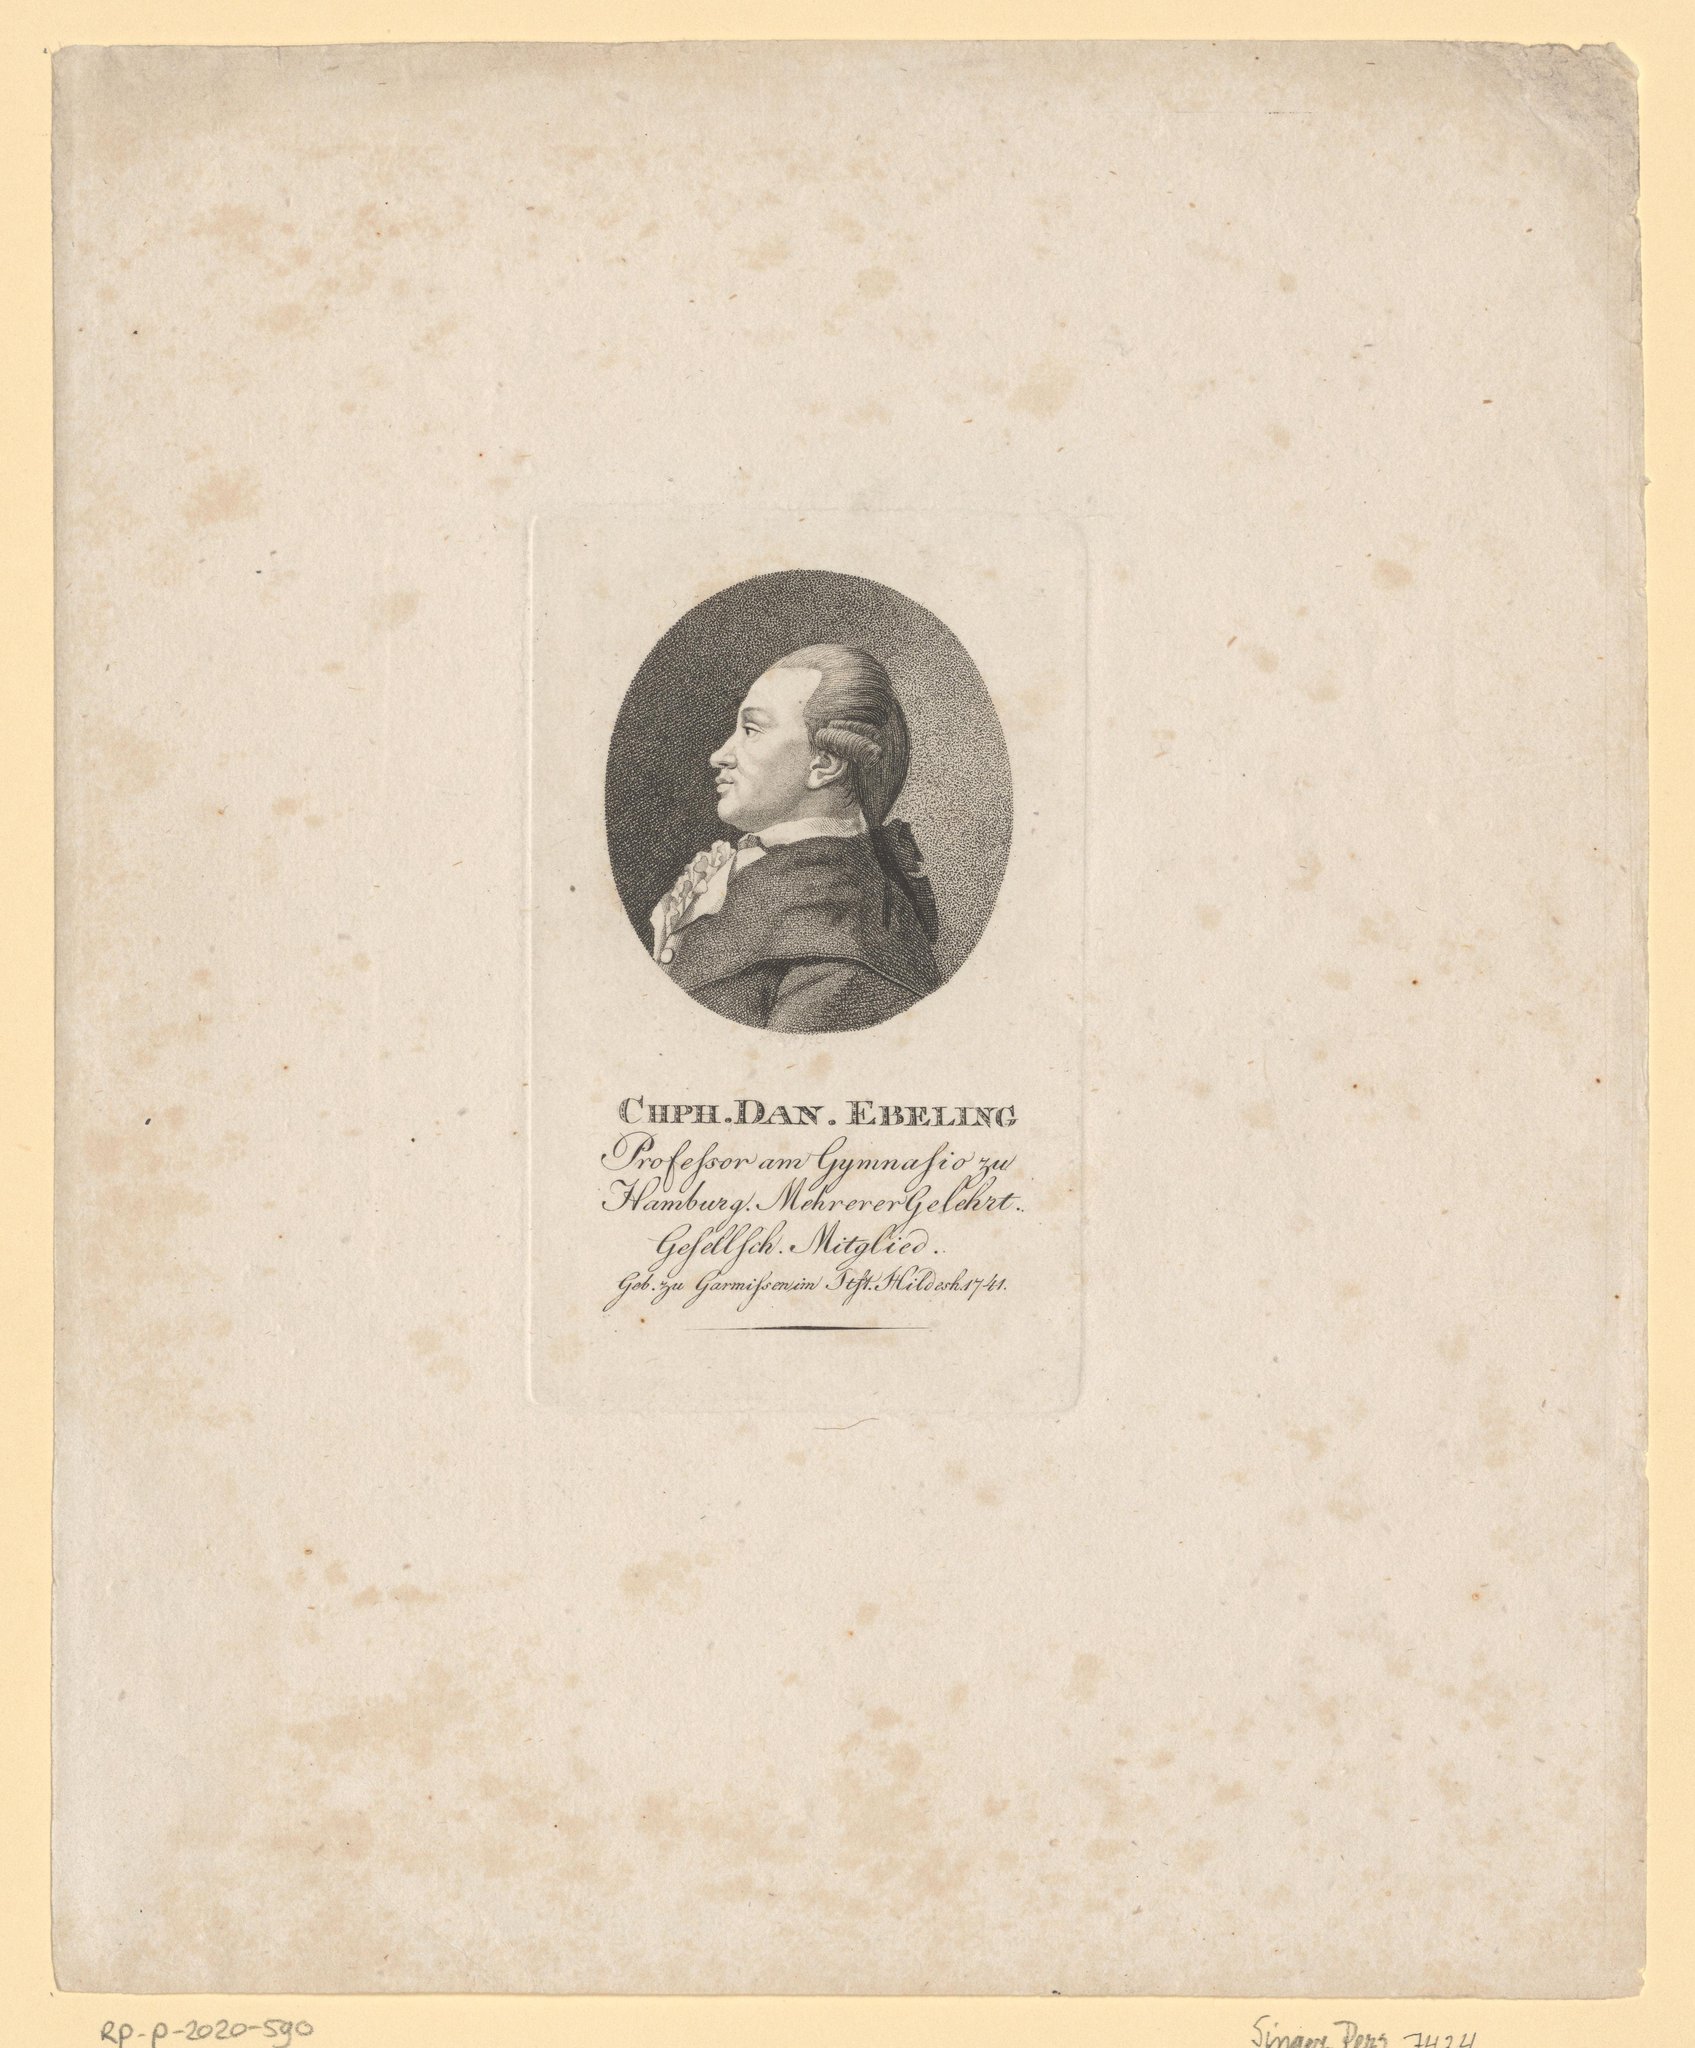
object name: book illustration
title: Portret van Christoph Daniel Ebeling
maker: adam weise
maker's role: painter, print maker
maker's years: 1776-1835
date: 1800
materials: paper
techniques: etching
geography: germany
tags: historical persons, professor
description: Prent waarschijnlijk uit: Allgemeine geographische Ephemeriden. Weimar: Industrie-Comptoir, 1800, dl. 5.